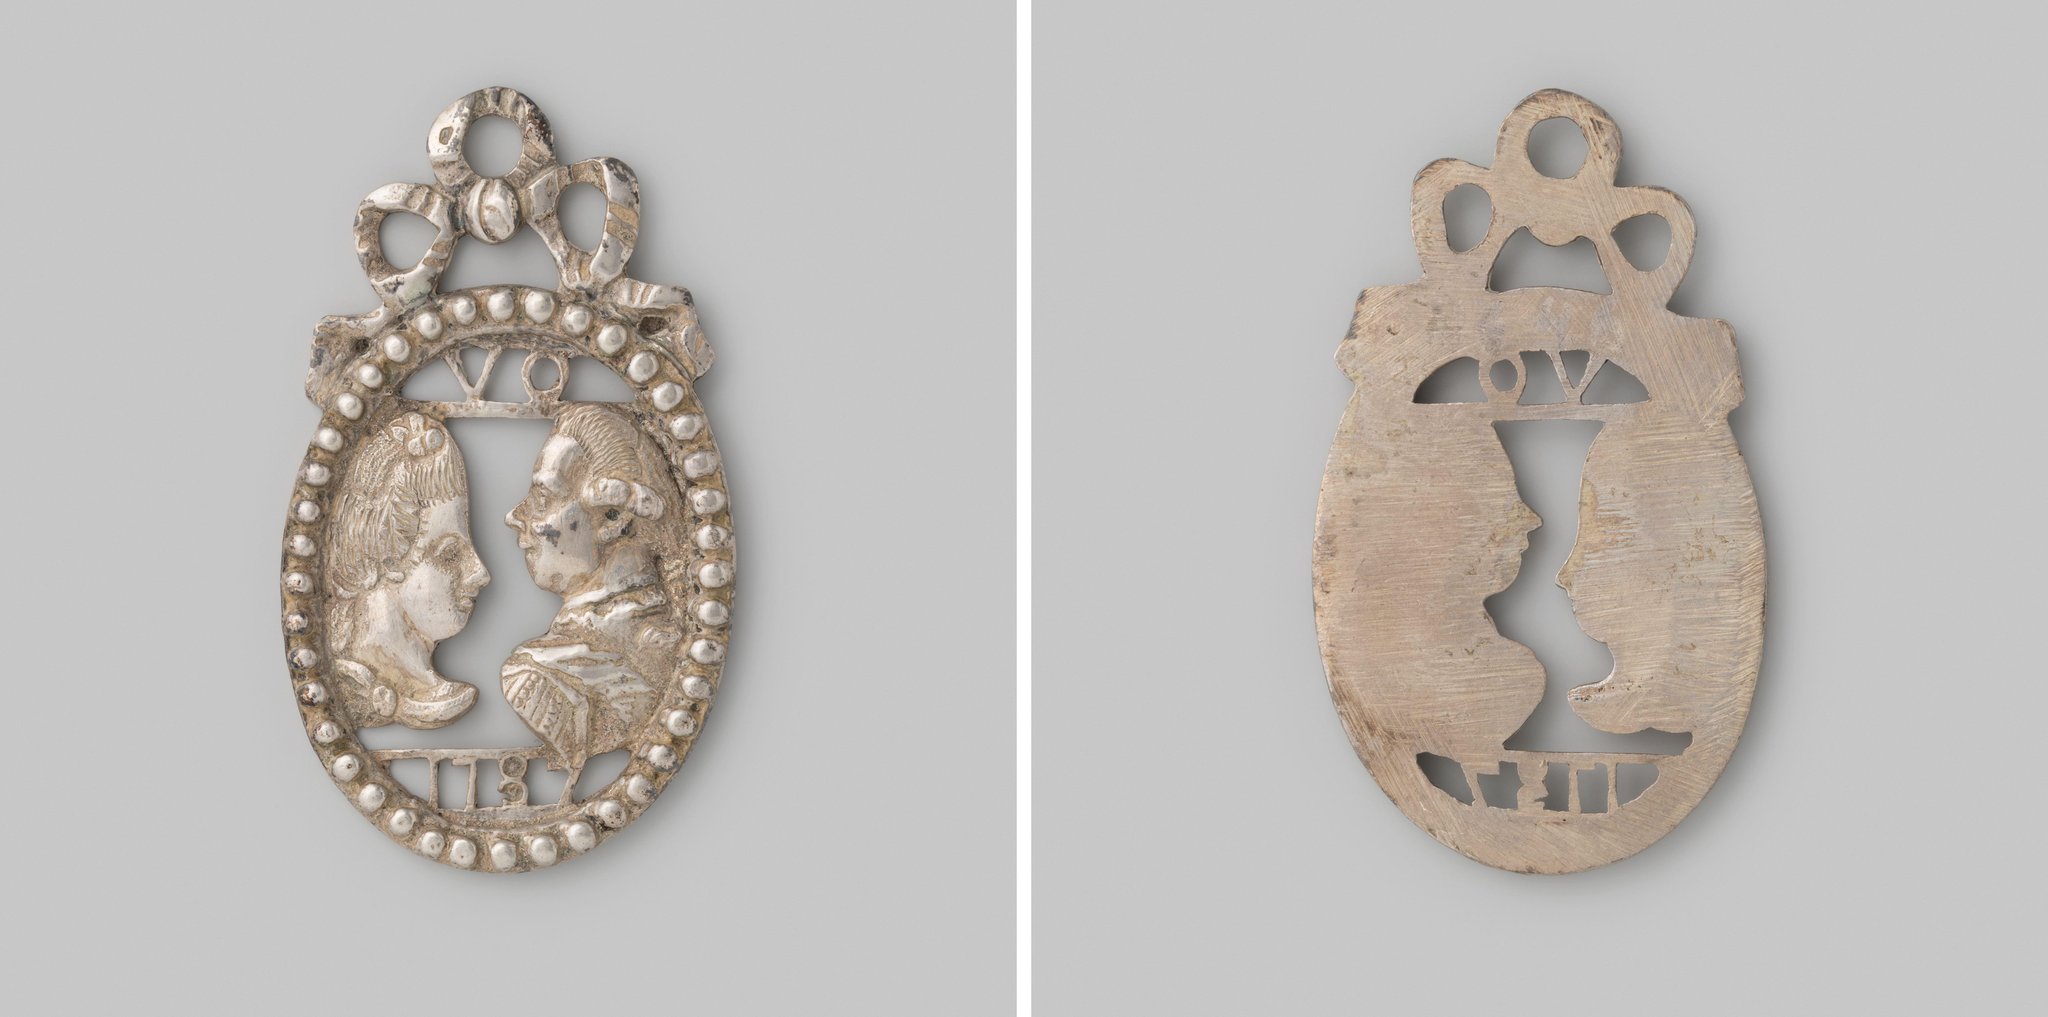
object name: insignia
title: Willem V en Wilhelmina van Pruisen, prins en prinses van Oranje-Nassau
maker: Anonymous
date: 1787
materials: silver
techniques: embroidery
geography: netherlands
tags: the hague, william v (prince of orange), berlin, painter, draughtsman, wilhelmina of prussia (princess of orange)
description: Eenzijdig zilveren ovaal opengewerkt draagteken in relief, aan bovenzijde versierd met opengewerkte strik met drie lussen. Voorzijde: naar elkaar gewende borststukken van man en vrouw onder opschrift boven jaartal binnen parelrand. Keerzijde: blanco